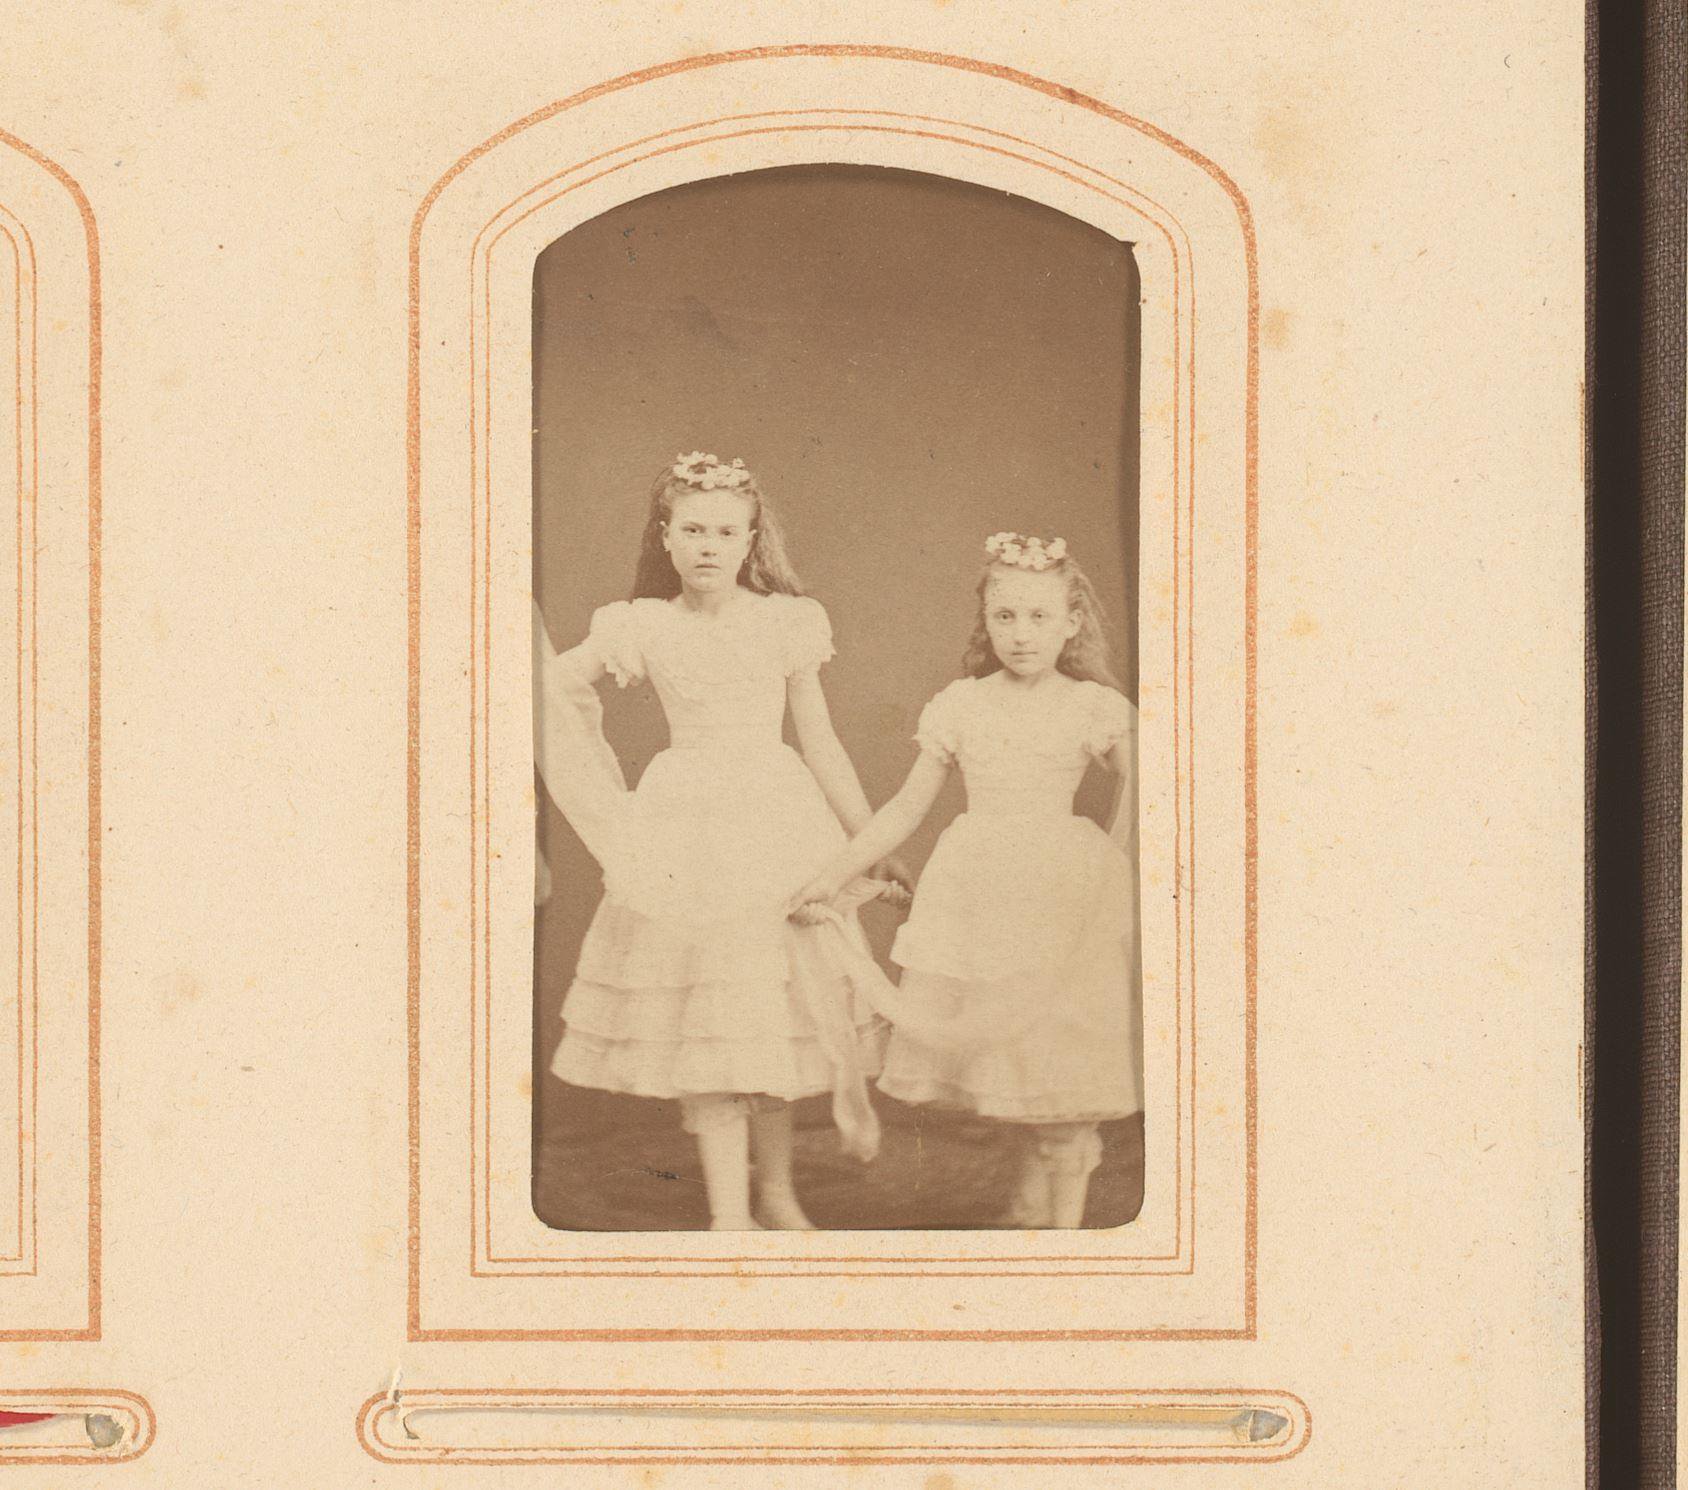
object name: album leaf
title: Portret van danseressen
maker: Anonymous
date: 1855-1890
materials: cardboard, photographic support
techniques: albumen print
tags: historical persons, girl (child between toddler and youth), portrait of dancer